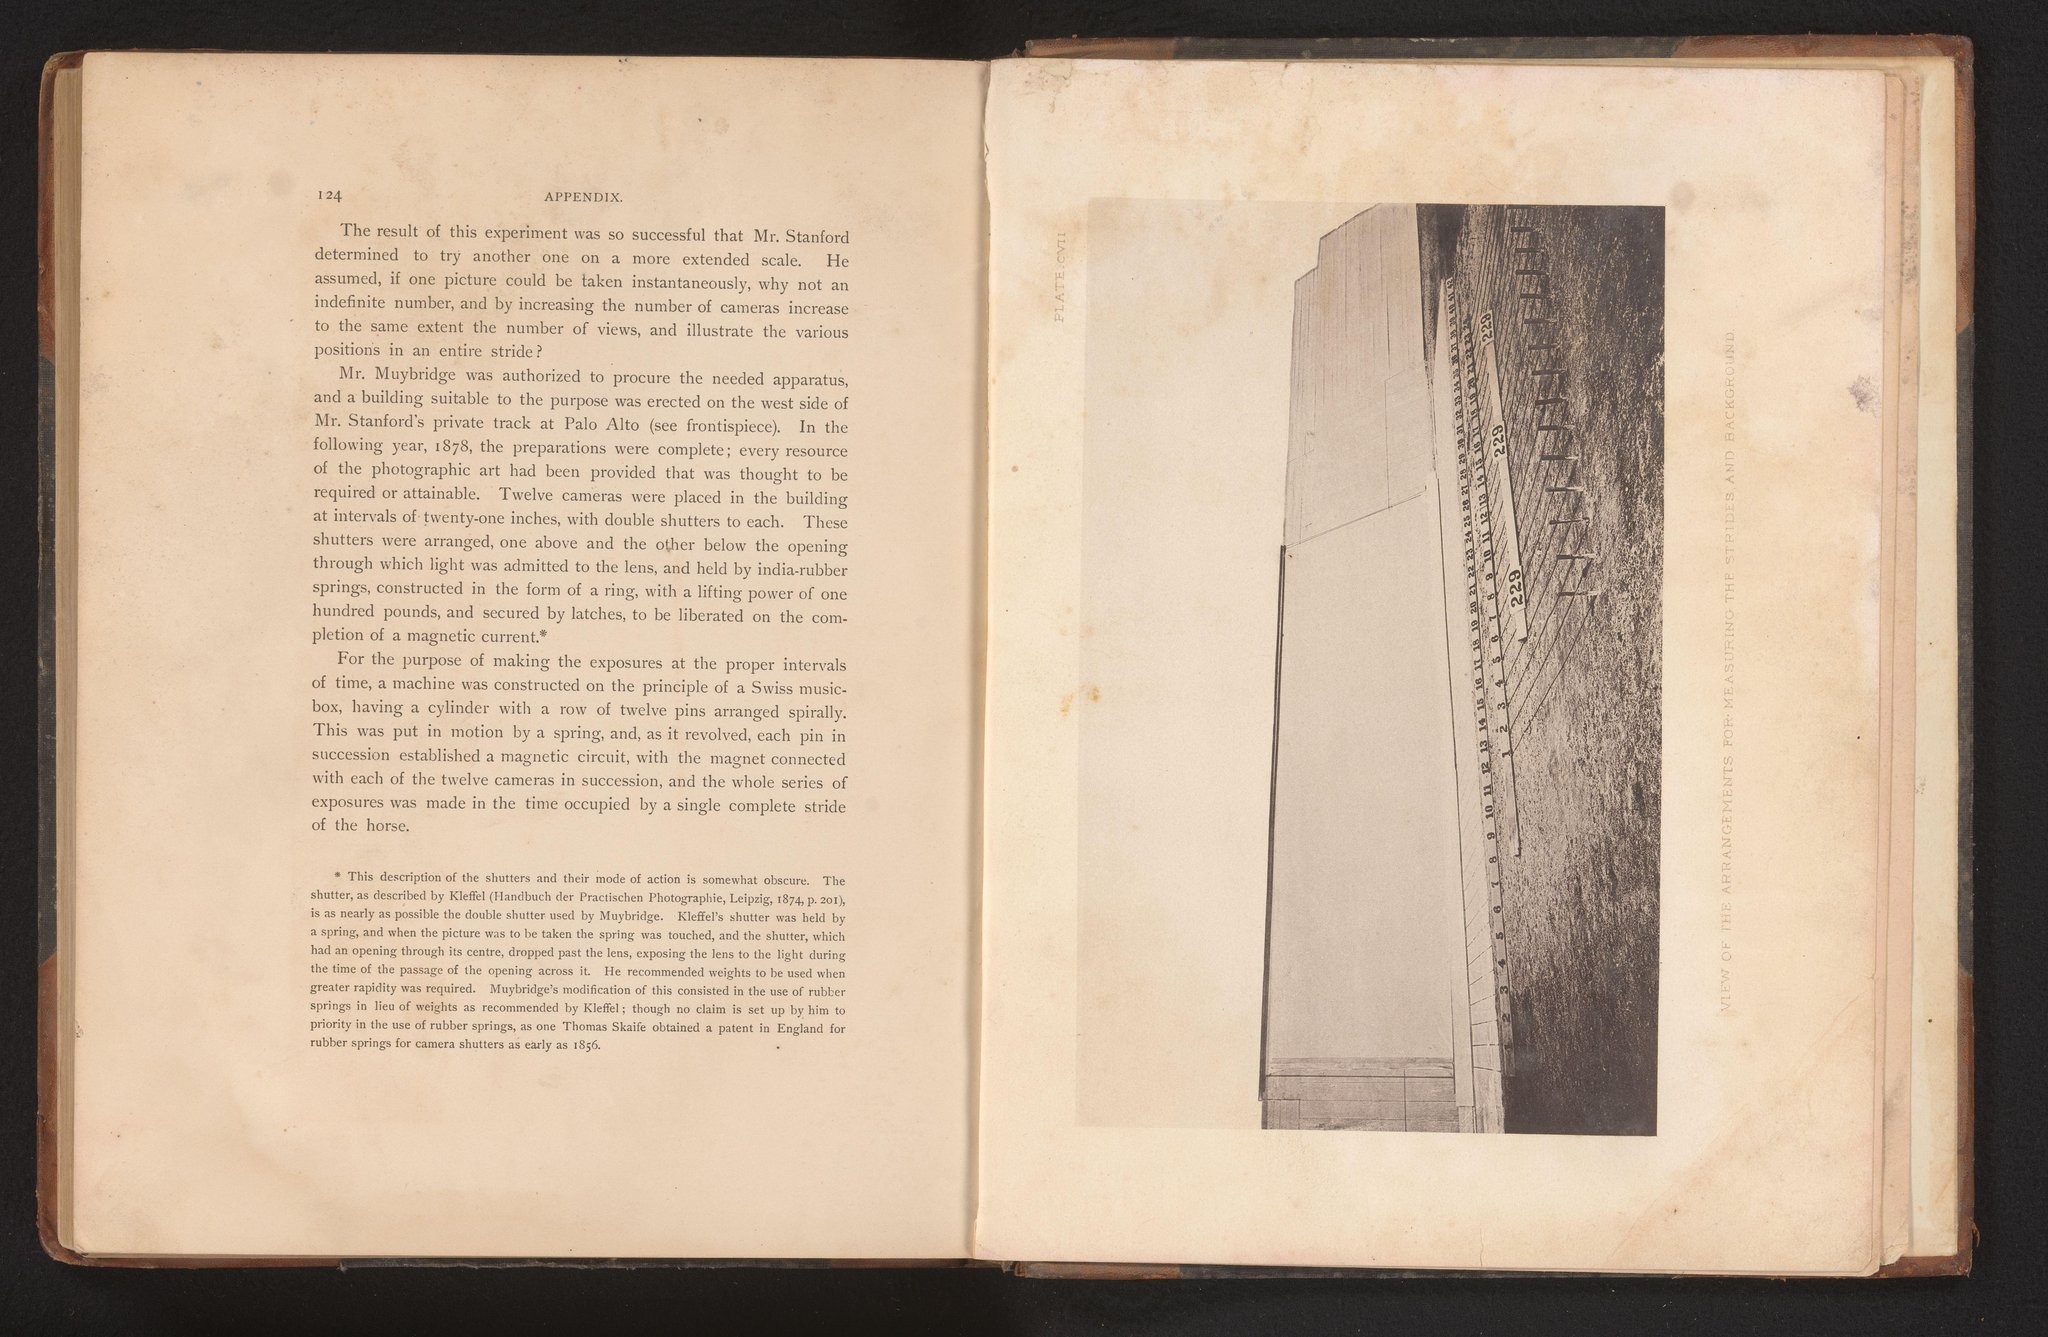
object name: page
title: View of the arrangements for measuring the strides and background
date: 1877-1882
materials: paper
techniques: heliotype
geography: palo alto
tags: research, experiment (~ production), measuring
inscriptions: inscription: ‘Plate CVII.’